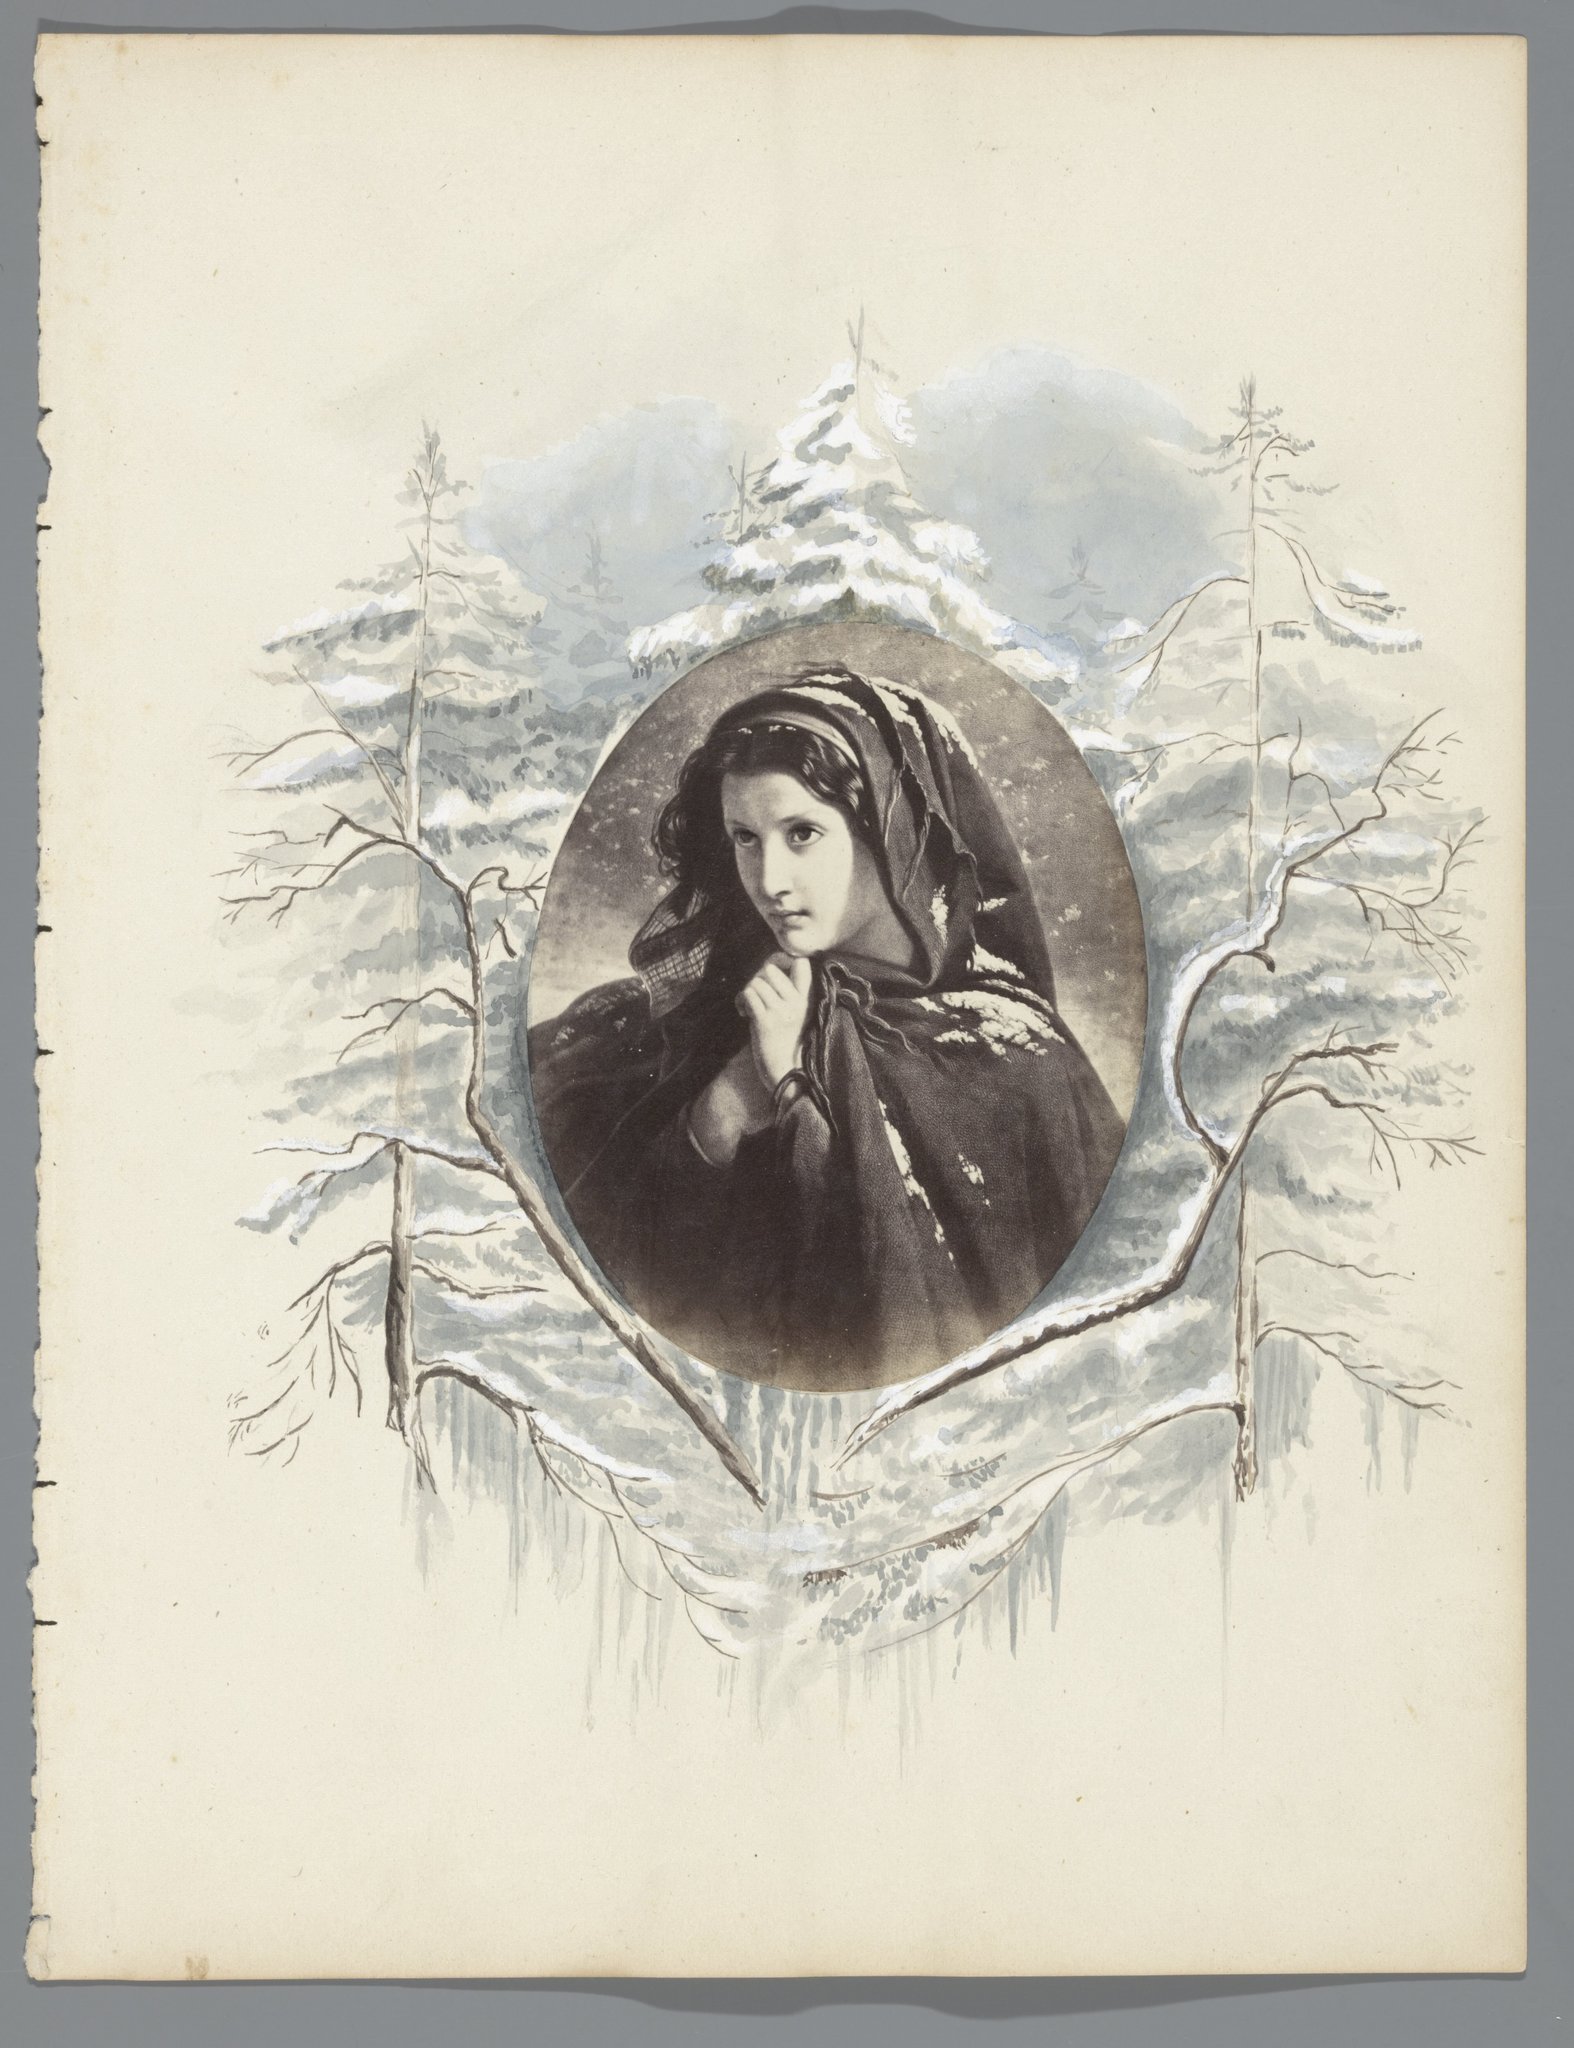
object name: reproduction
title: Fotoreproductie van een geschilderd portret van een onbekende vrouw in de sneeuw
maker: Anonymous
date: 1870-1890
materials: paper, watercolor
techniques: albumen print, brush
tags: trees, coat, anonymous historical person portrayed, snow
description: Los albumblad met een foto van een ovaal schilderij van een vrouw in de sneeuw. Versierd met besneeuwde bomen in de winter. Behorend bij fotoalbum met foto's omgeven door pentekeningen.